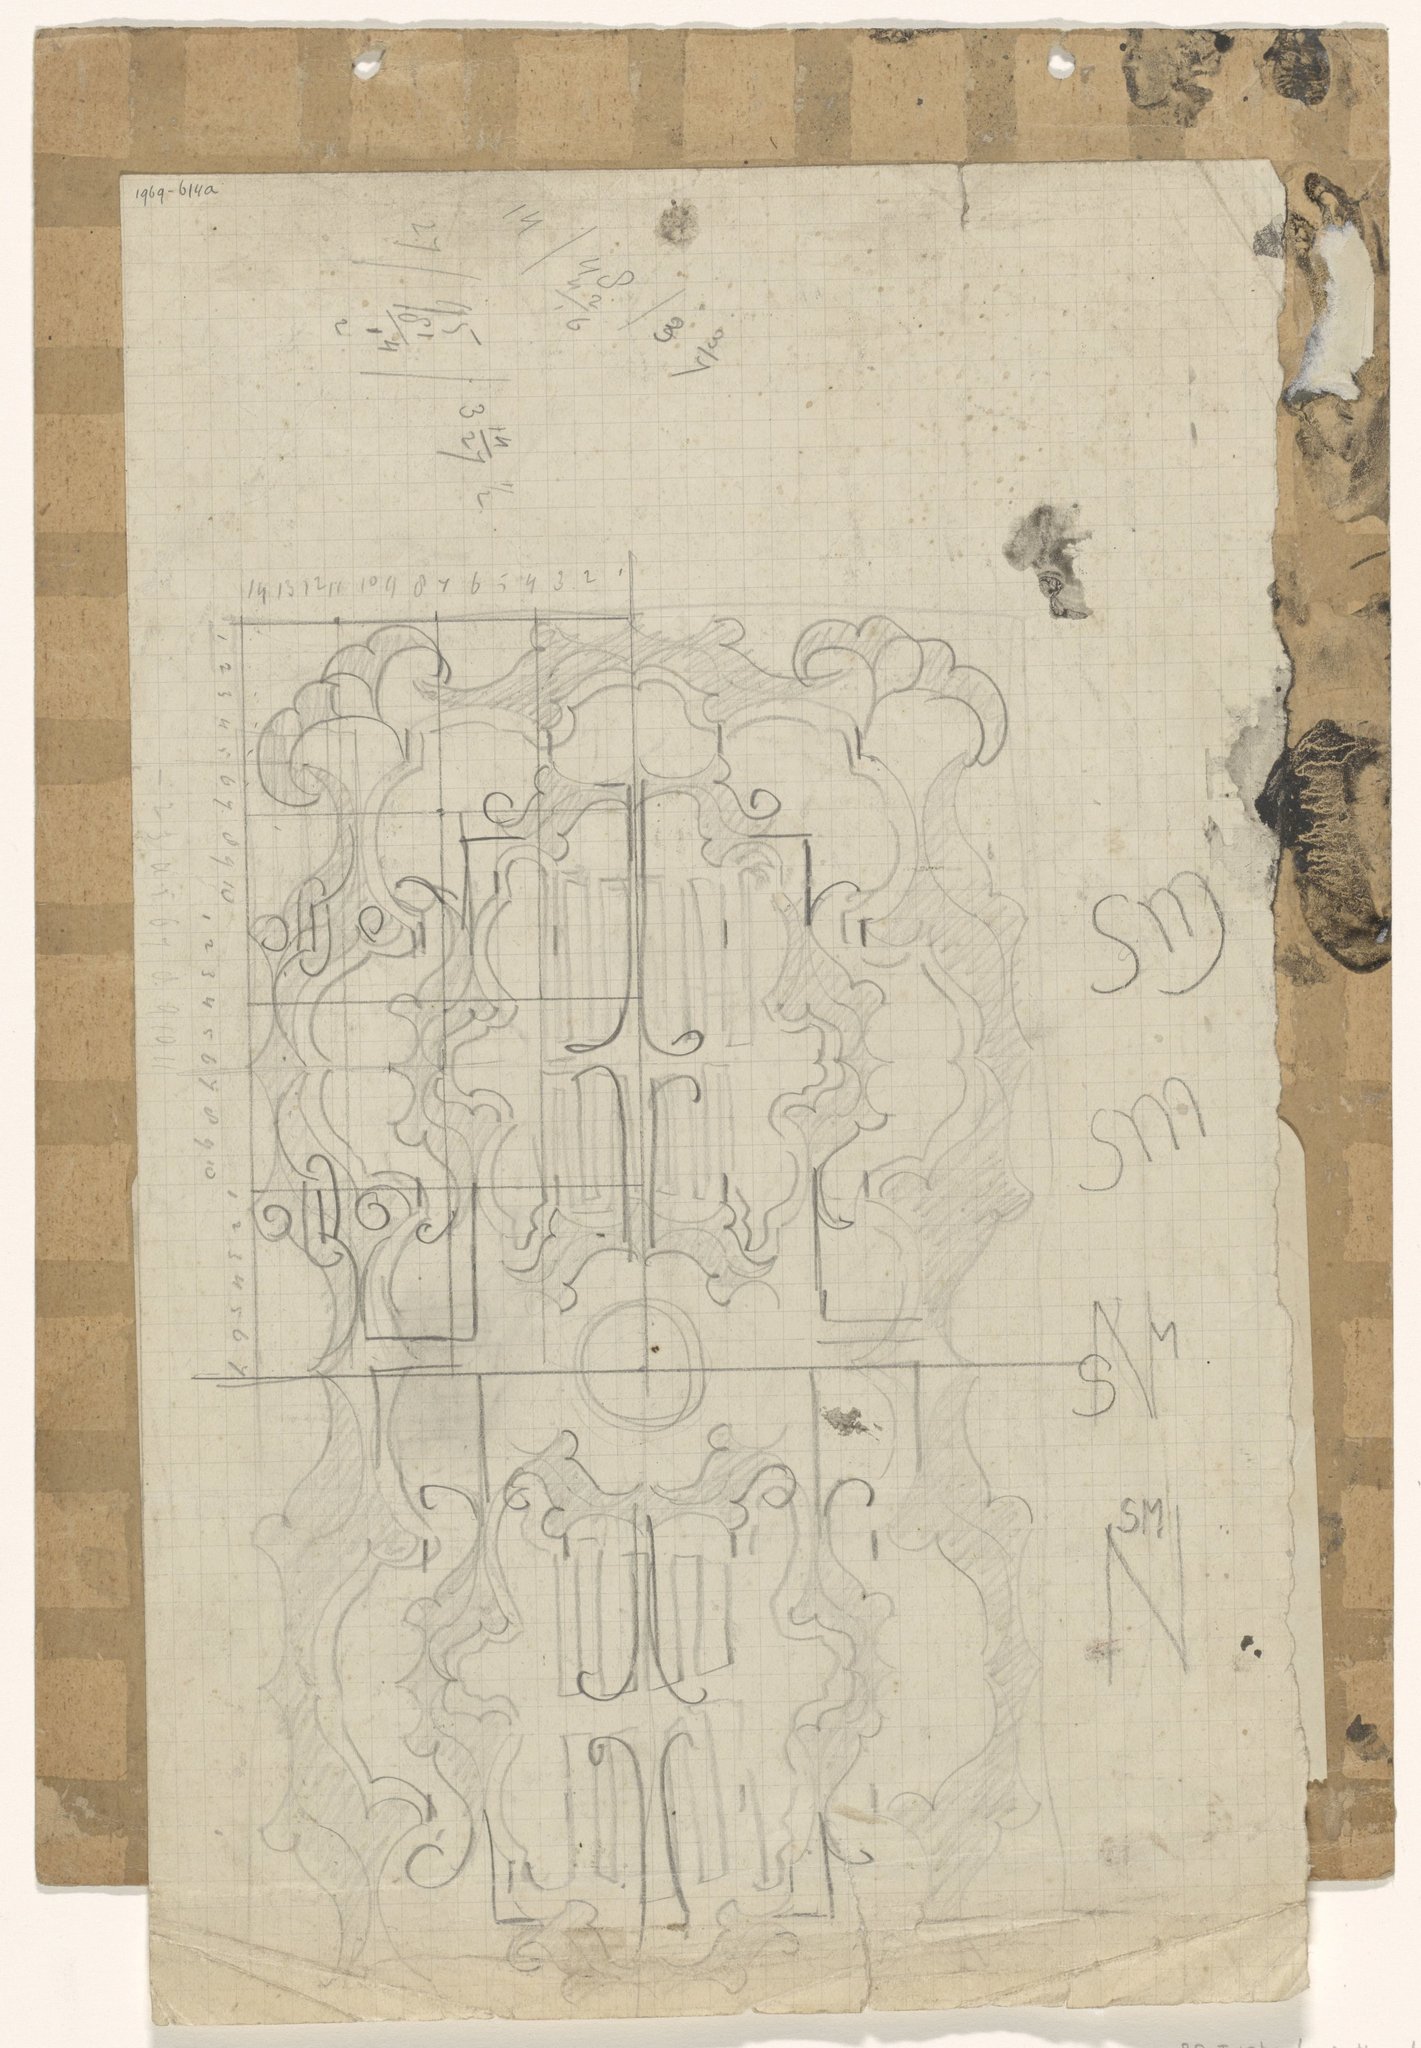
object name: design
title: Decoratief ontwerp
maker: carel adolph lion cachet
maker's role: draughtsman, print maker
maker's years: 1864-1945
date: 1874-1945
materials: pencil